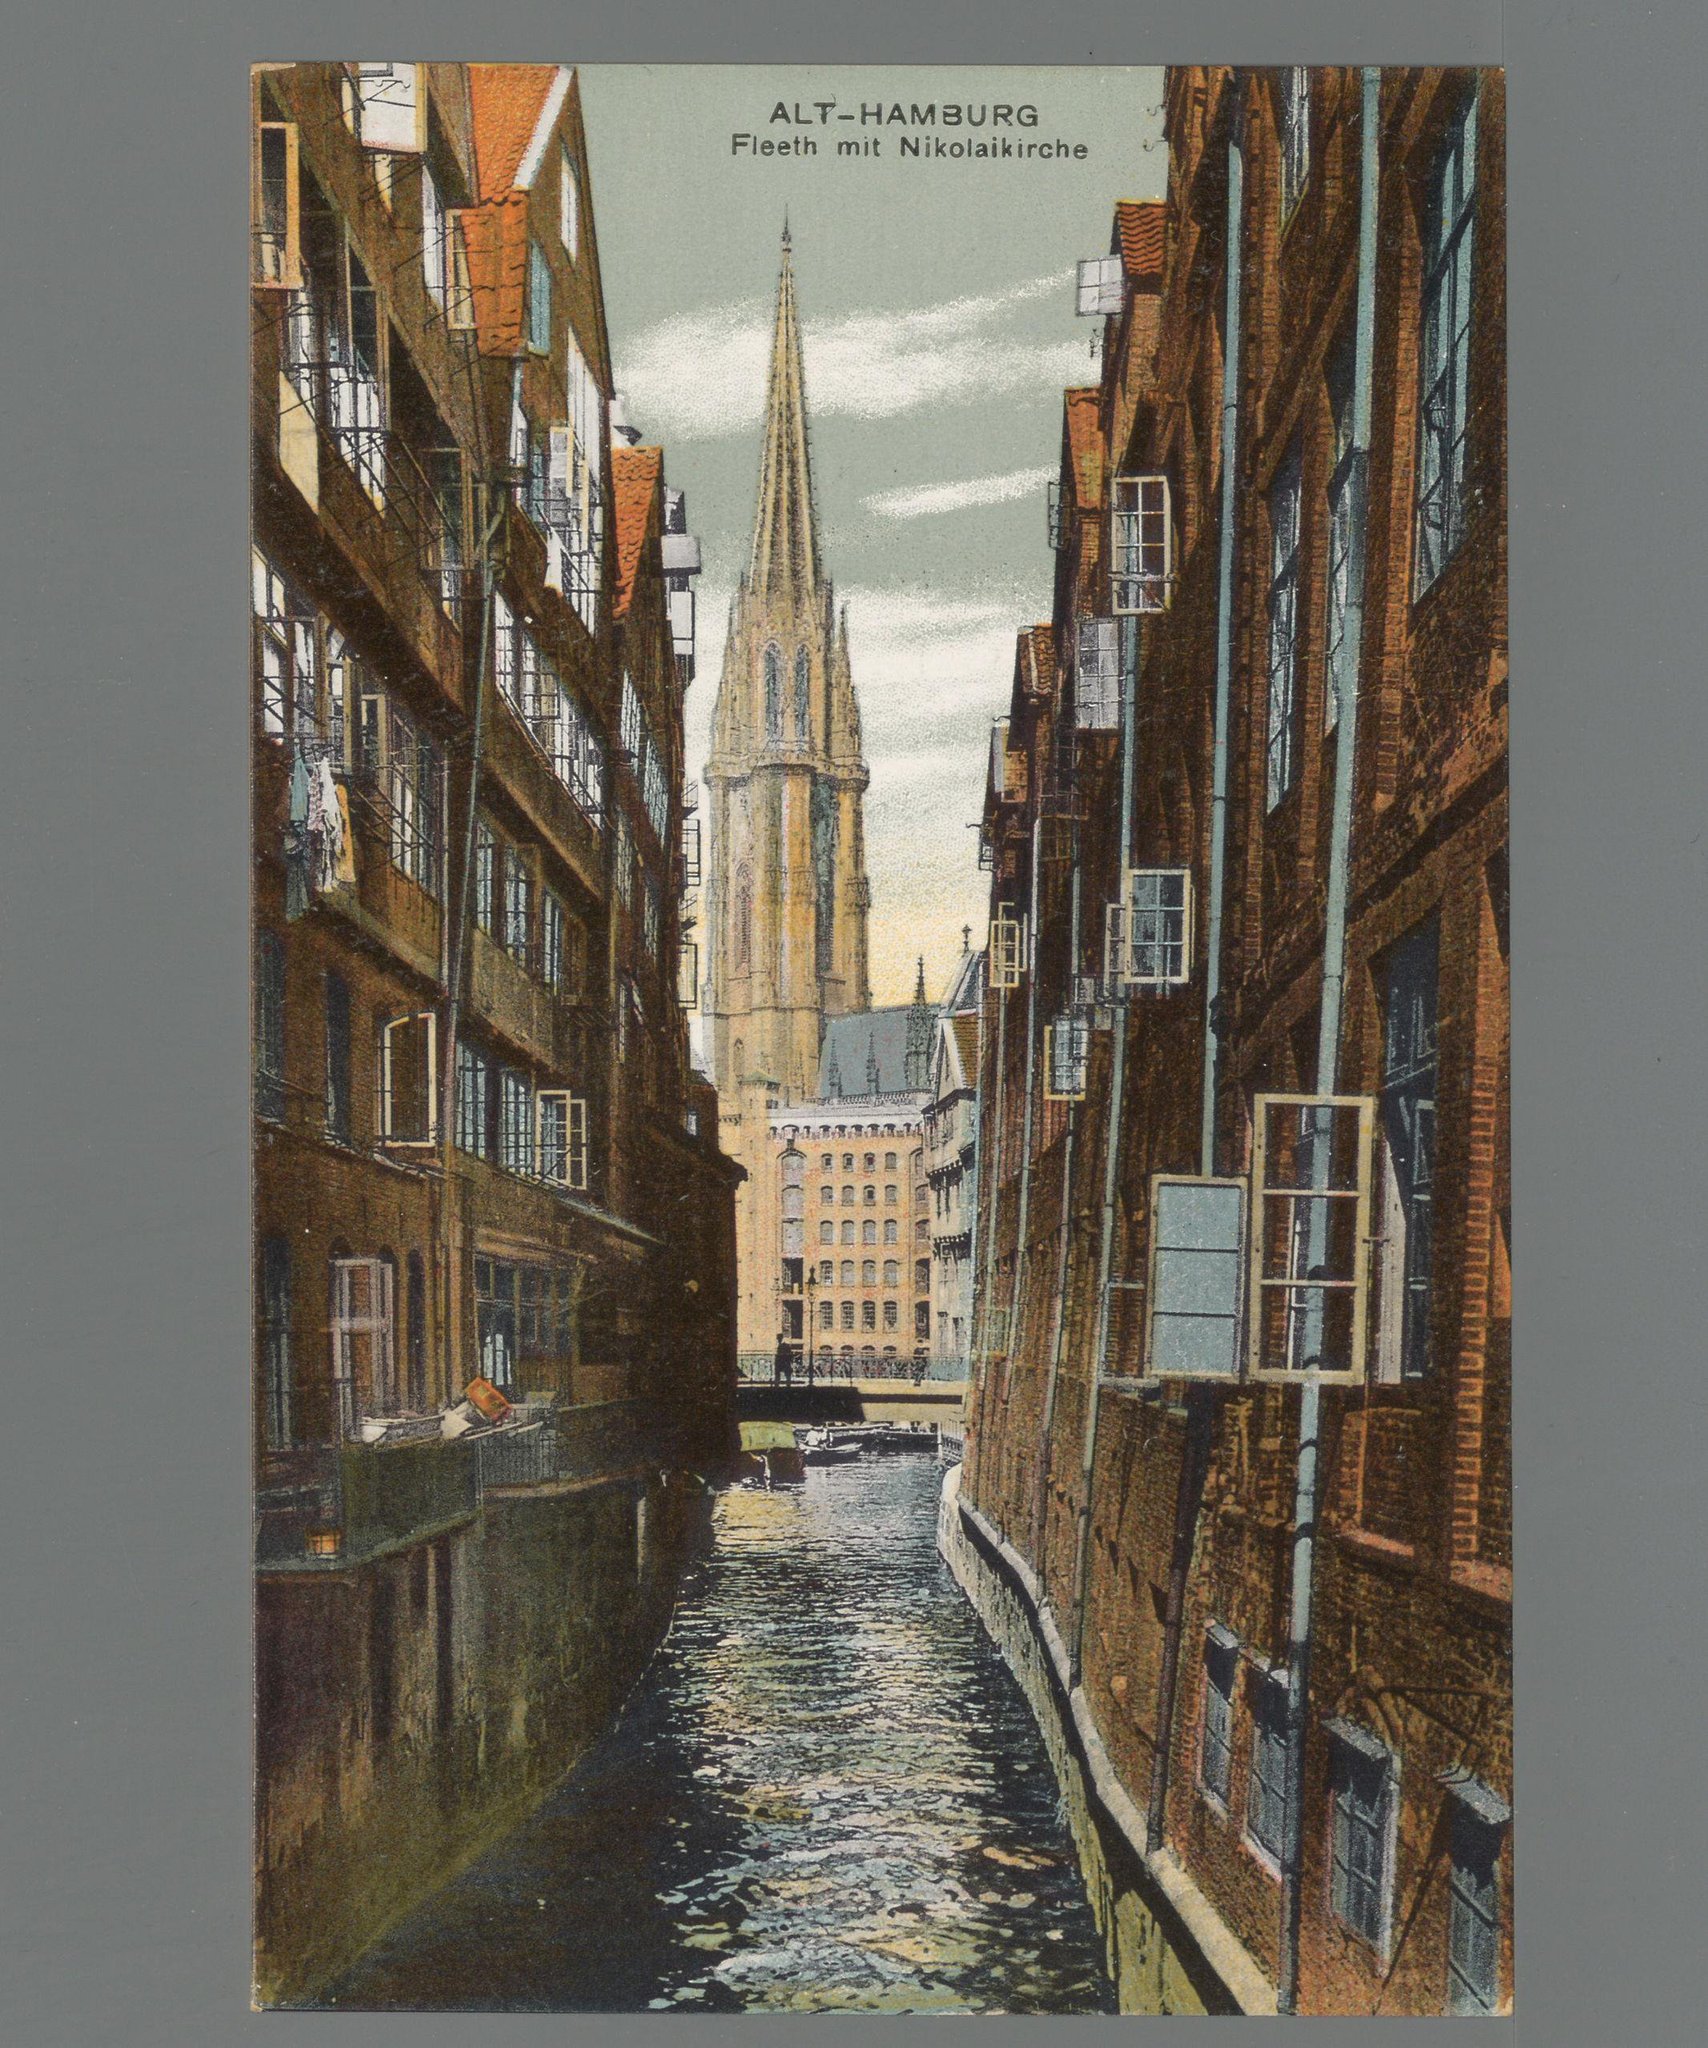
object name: ansichtkaart, prentbriefkaart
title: Alt-Hamburg. Fleeth mit Nikolaikirche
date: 1905-1930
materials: cardboard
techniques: photograph, lithograph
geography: hamburg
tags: church (exterior), canals, waters (in city), street